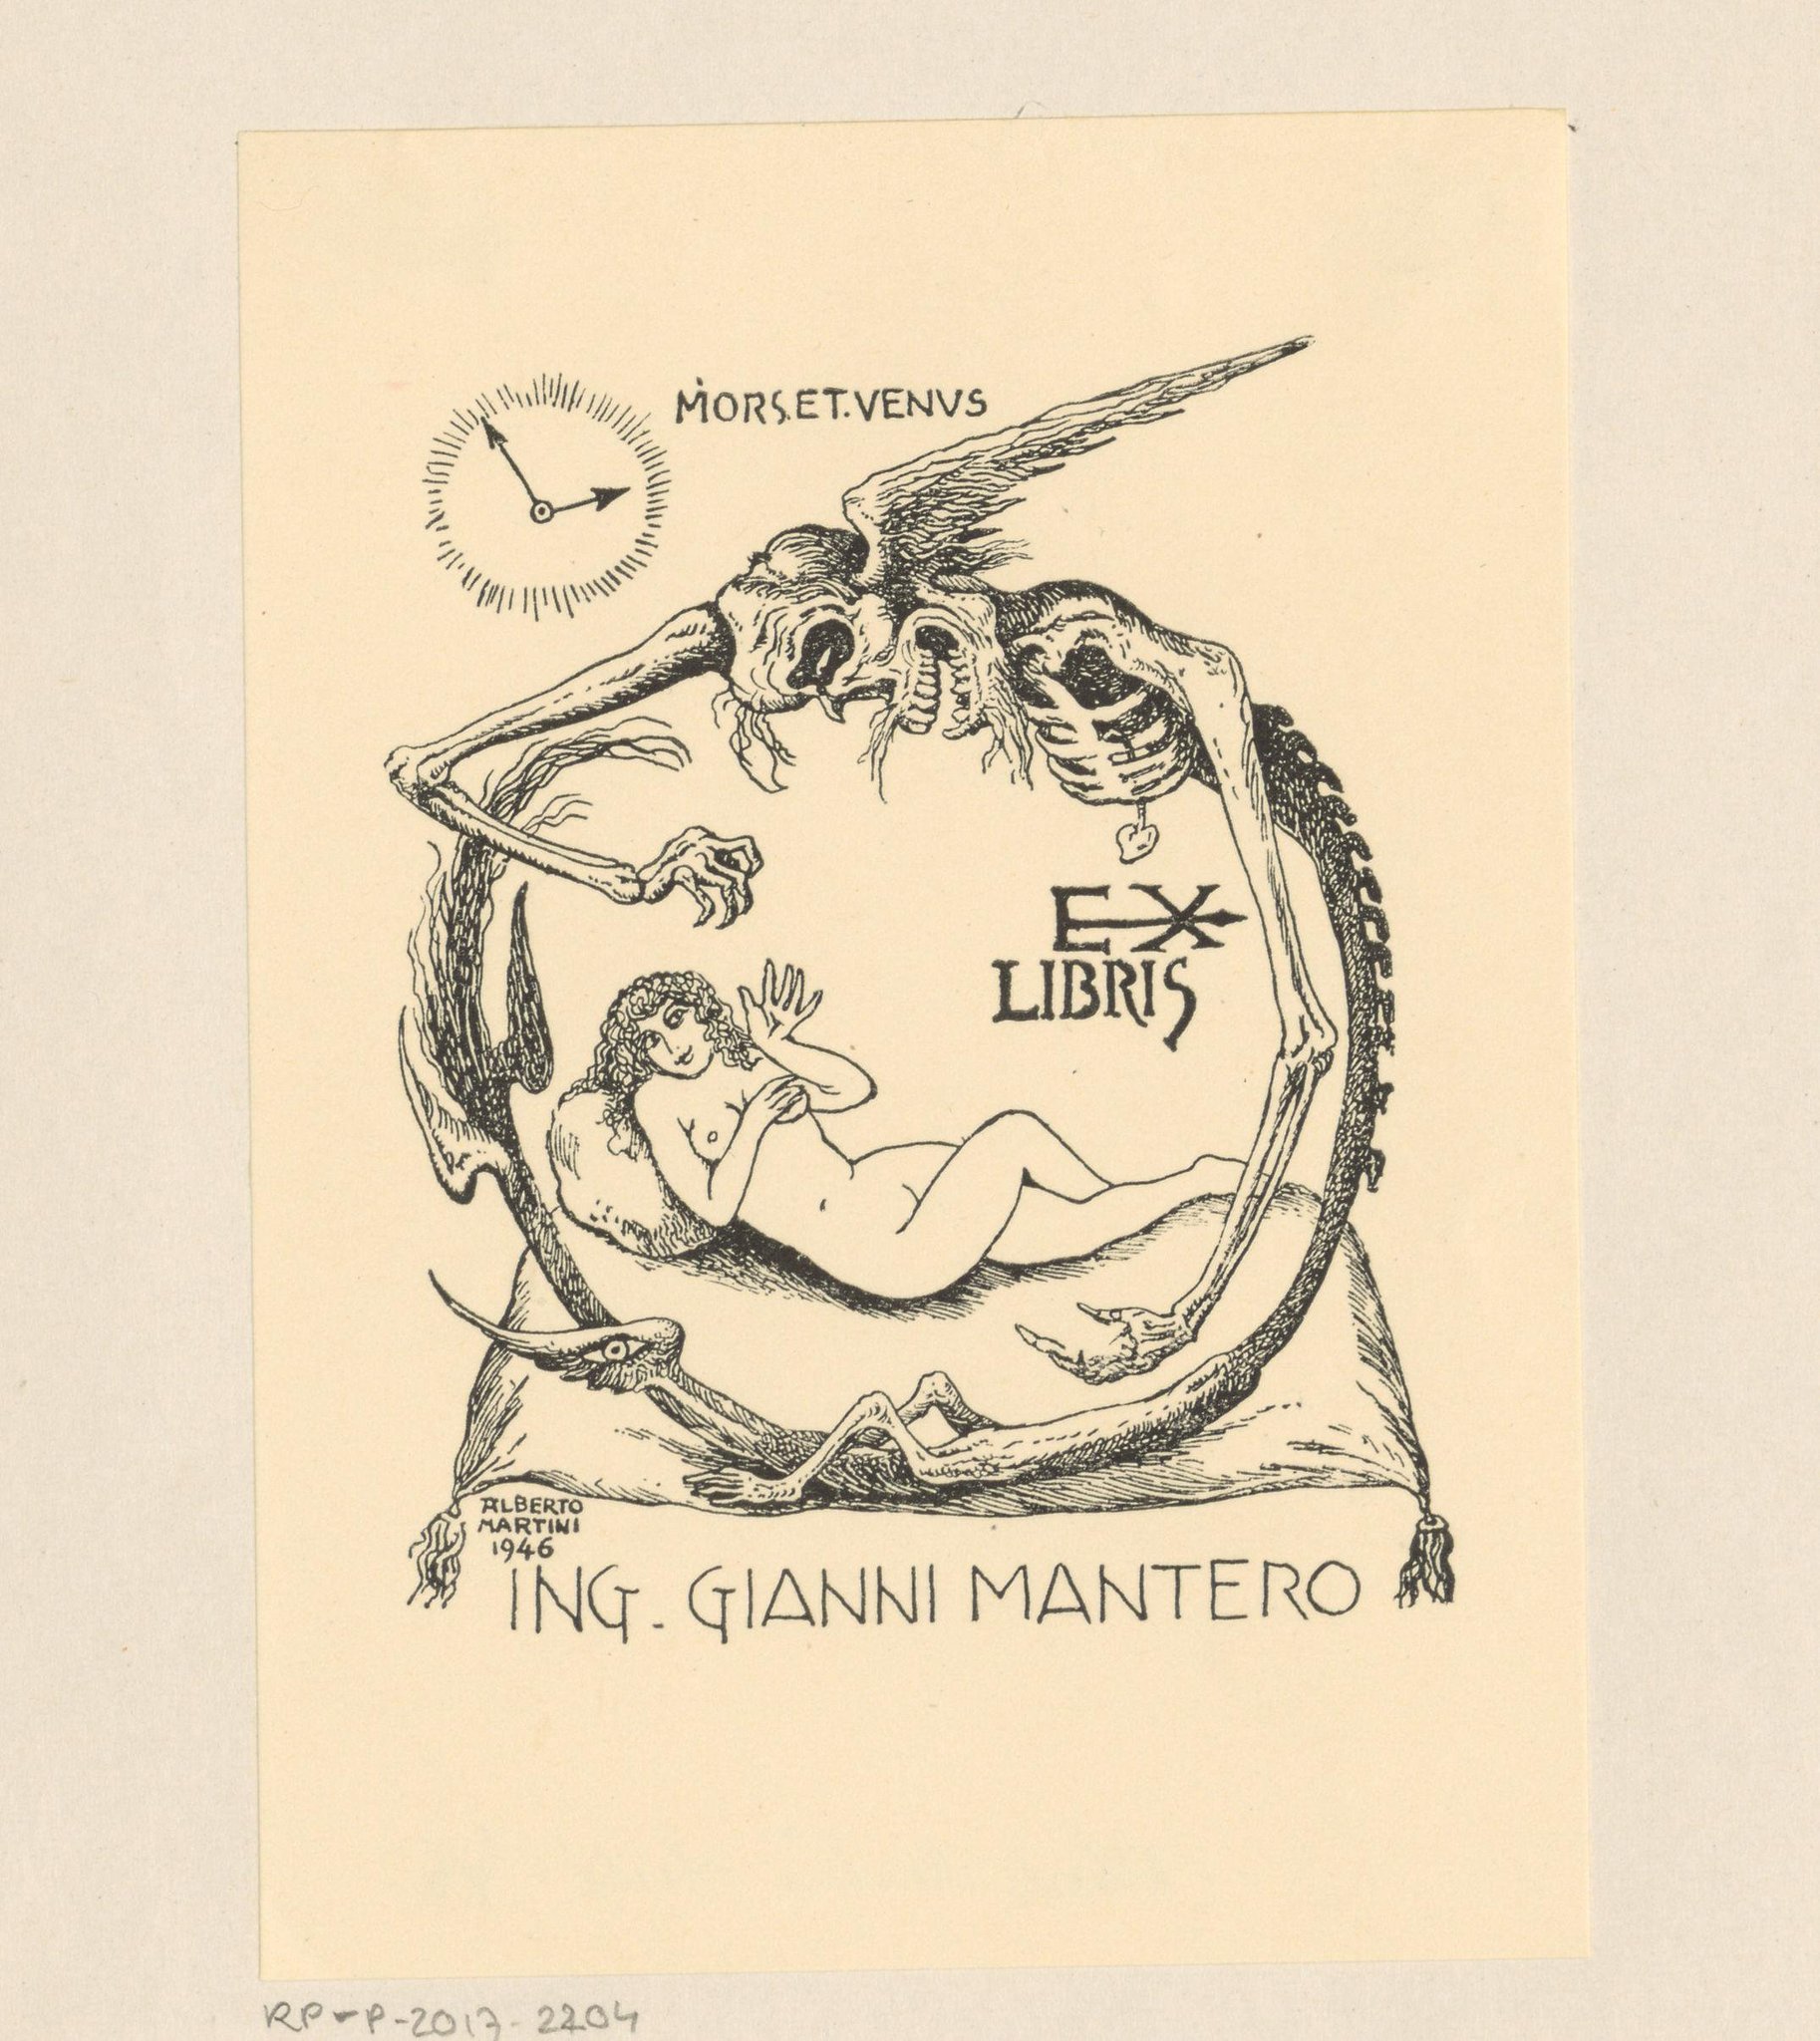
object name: bookplate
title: Ex libris van Gianni Mantero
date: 1946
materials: paper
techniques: printing block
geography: italy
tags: engineer, gianni mantero, death as skeleton, woman (showing herself) undressed, quasi-nude, clock, lying figure - aa - female human figure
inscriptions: date